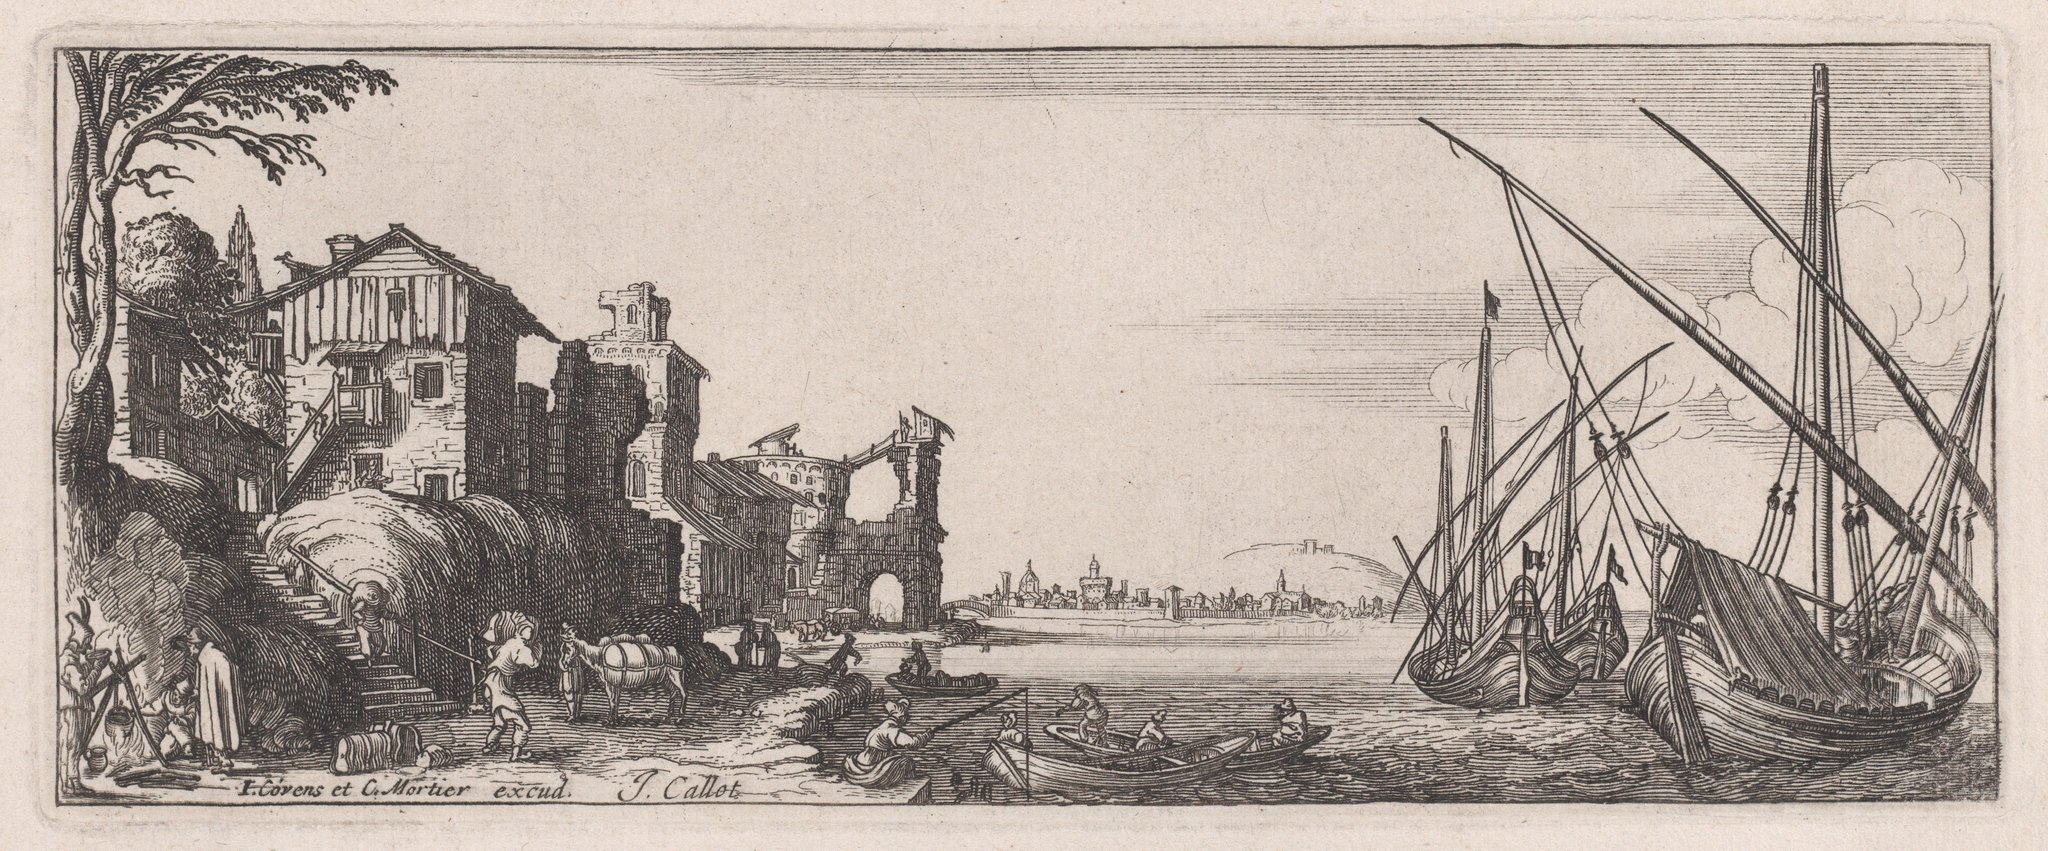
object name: print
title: Reverse Copy of Le Petit Port appelé aussi Le Port de Mer (The Small Port, also called the Sea Port), from "Les Quatre Paysages" (The Four Landscapes)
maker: Anonymous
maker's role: artist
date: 1601-1700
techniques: etching